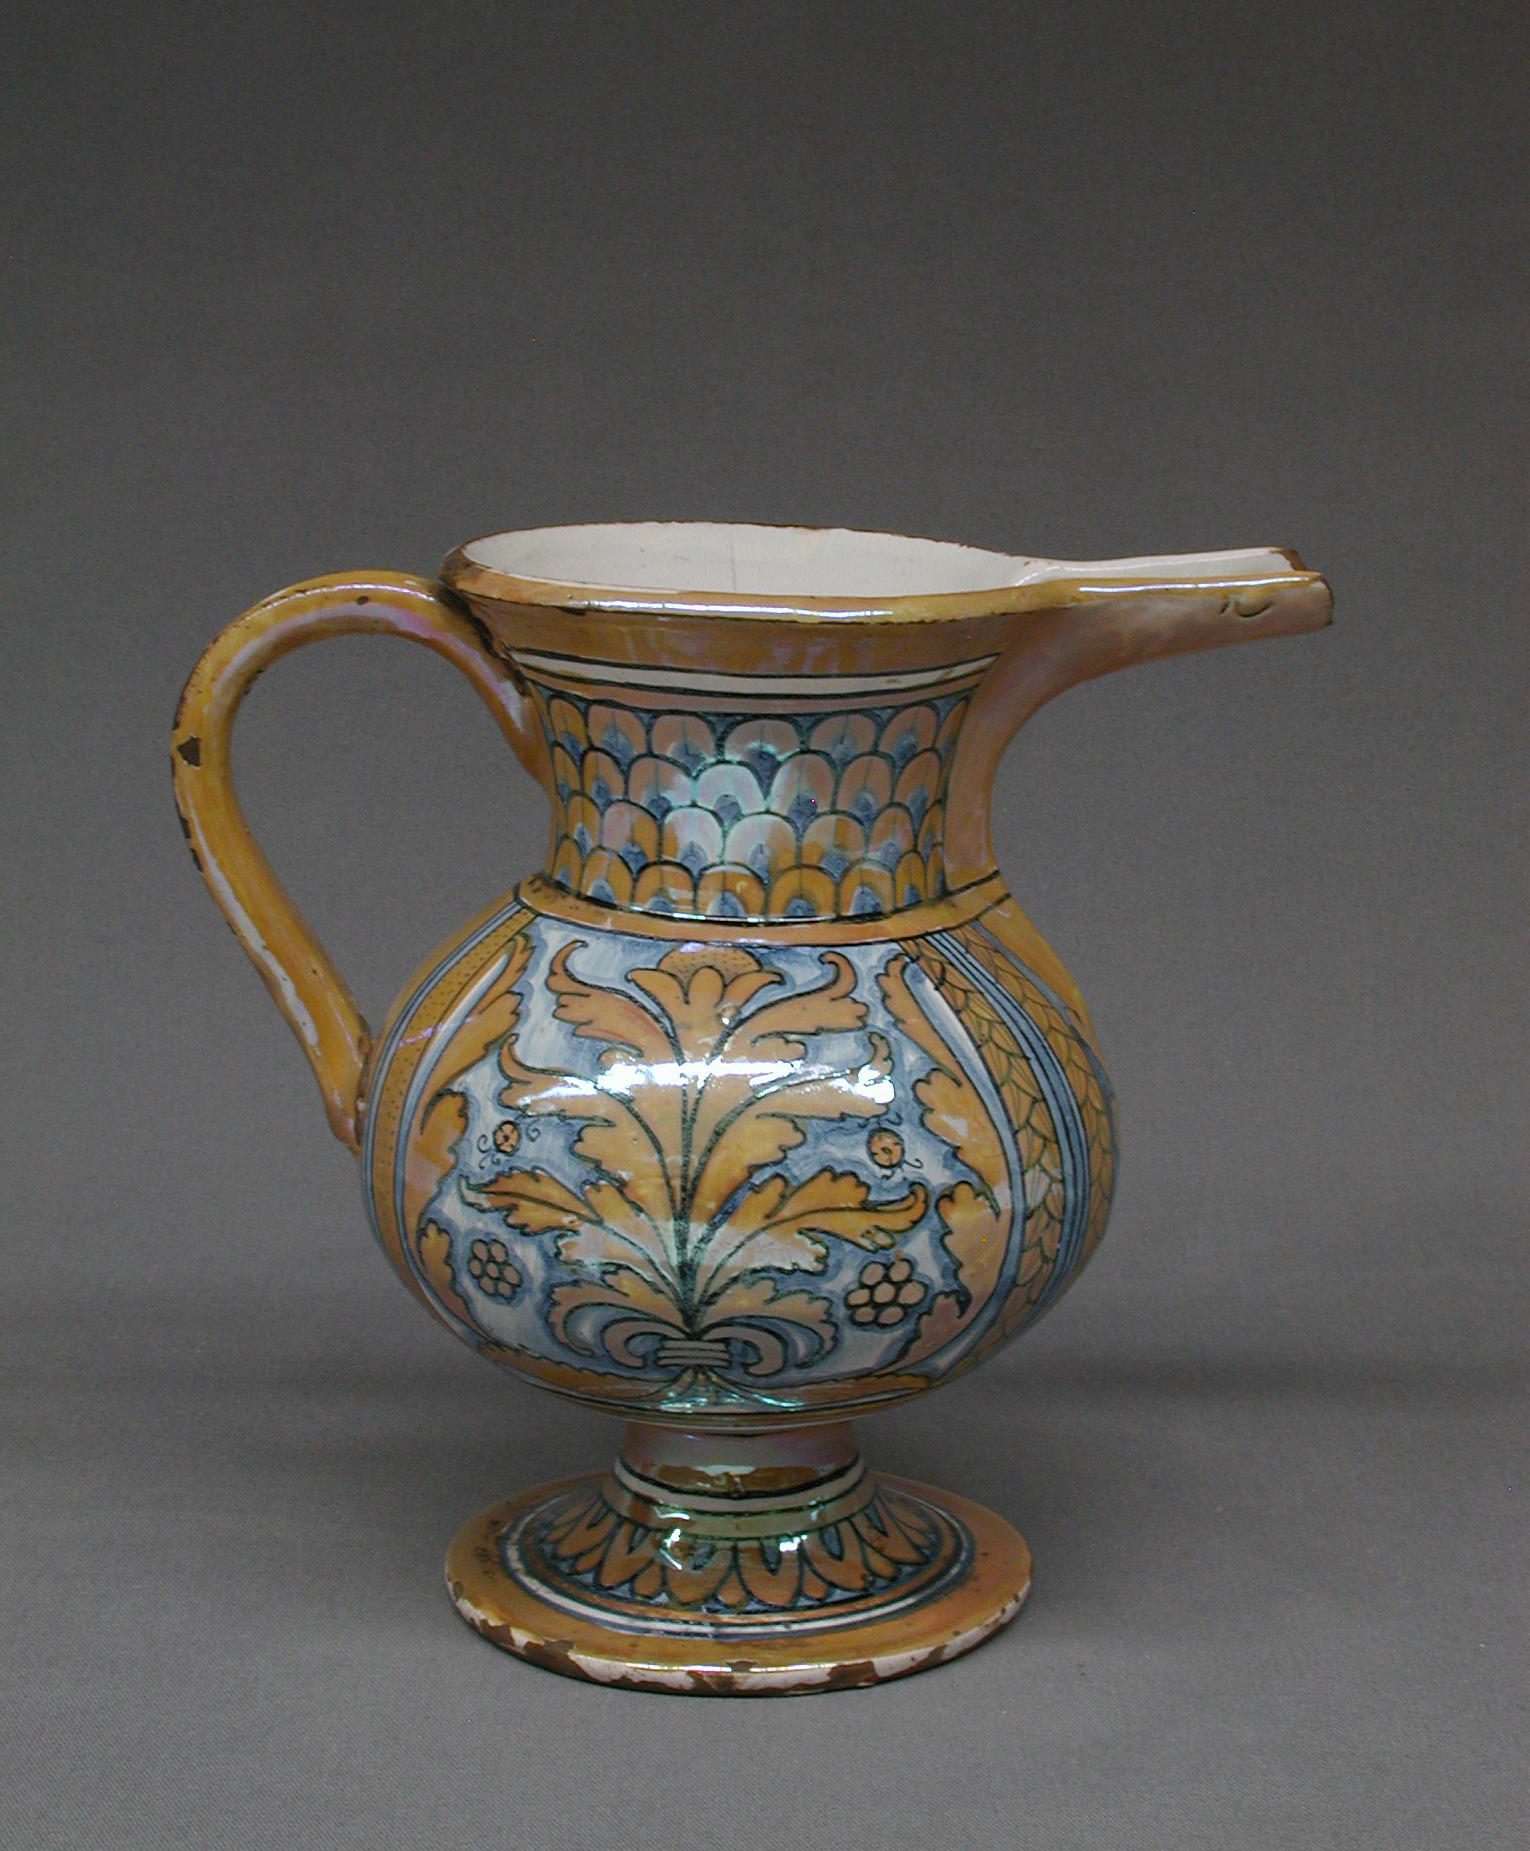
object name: ewer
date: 1520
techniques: maiolica, glazing